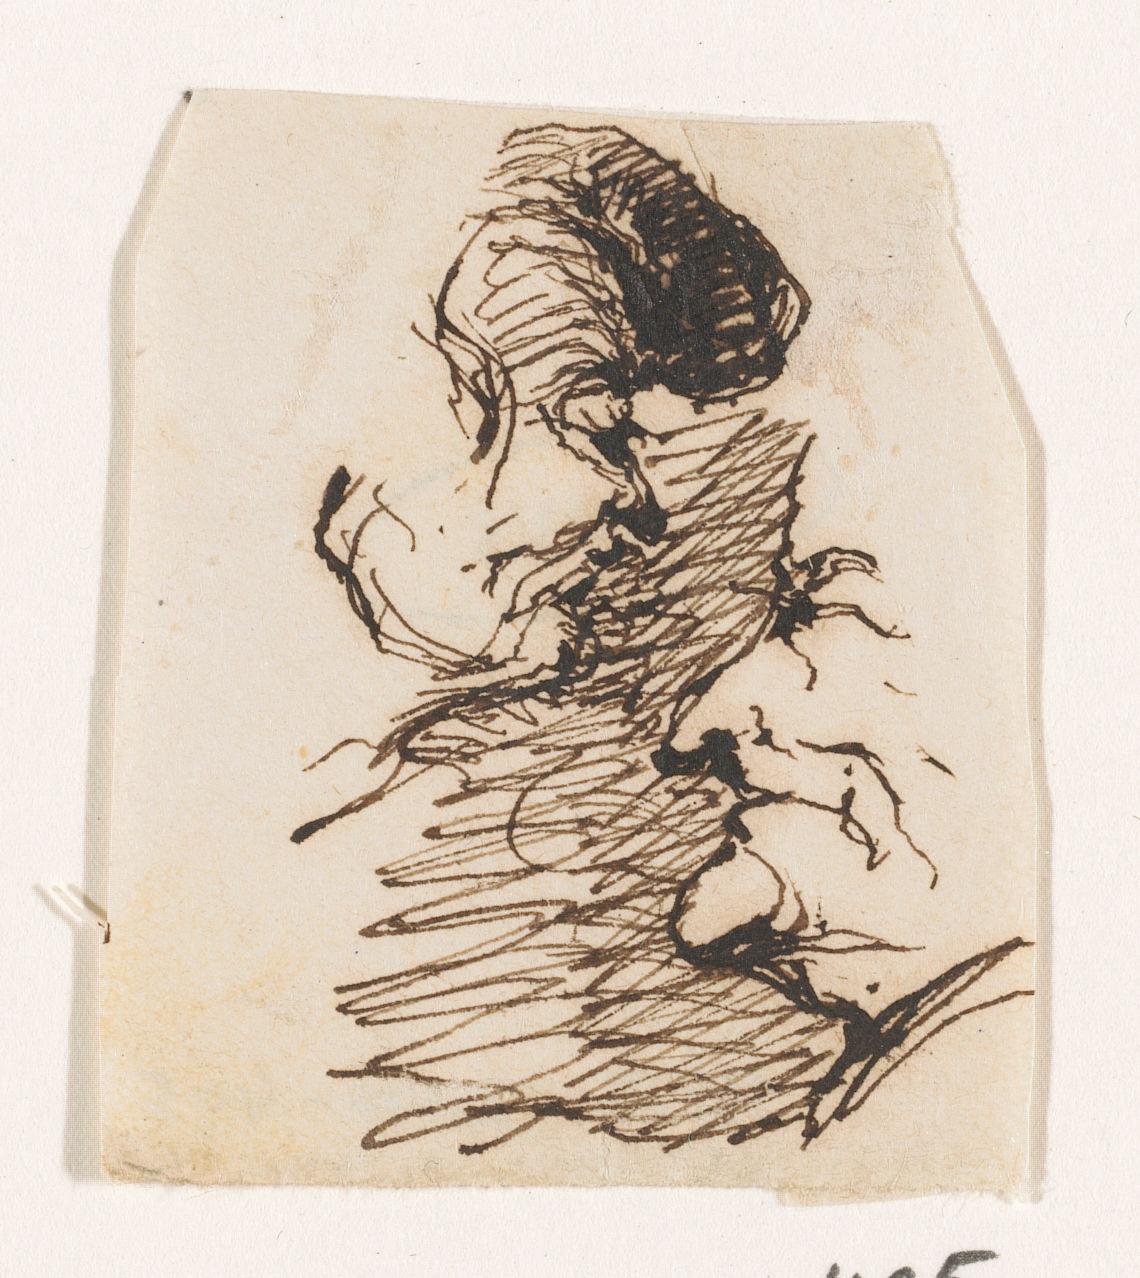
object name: drawing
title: Twee koppen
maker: johannes tavenraat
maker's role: draughtsman, painter, print maker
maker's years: 1809-1881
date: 1840-1880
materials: ink, paper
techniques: pen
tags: caricatures (human types)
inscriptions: collector's mark: Lugt 2228